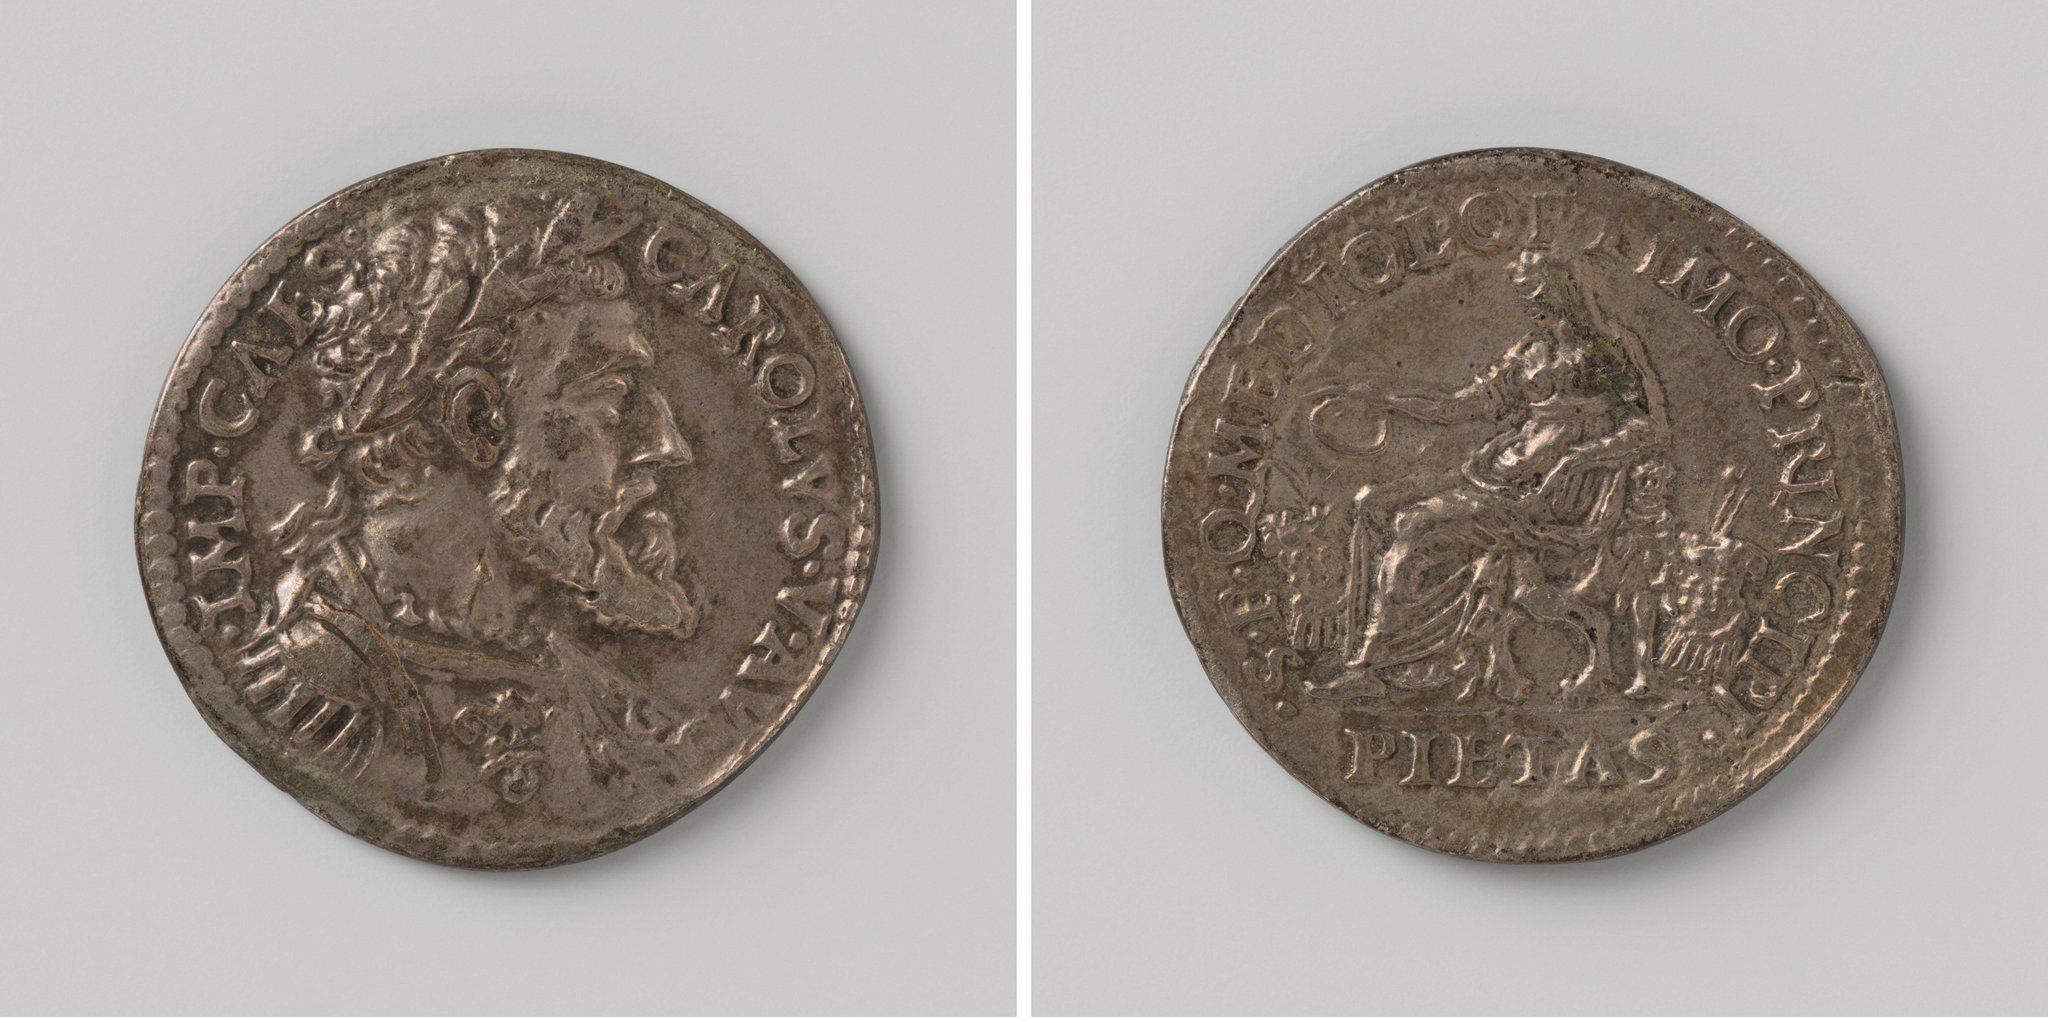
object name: history medal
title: Karel V herstelt Francesco II Sforza als hertog van Milaan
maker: Anonymous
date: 1529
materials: silver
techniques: striking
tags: ghent, charles v (holy roman emperor and king of spain)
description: Zilveren penning. Voorzijde: borststuk man met lauwerkrans binnen omschrift. Keerzijde: Godvruchtigheid met ring in handen, zittend tussen wapentuig binnen omschrift; afsnede: opschrift